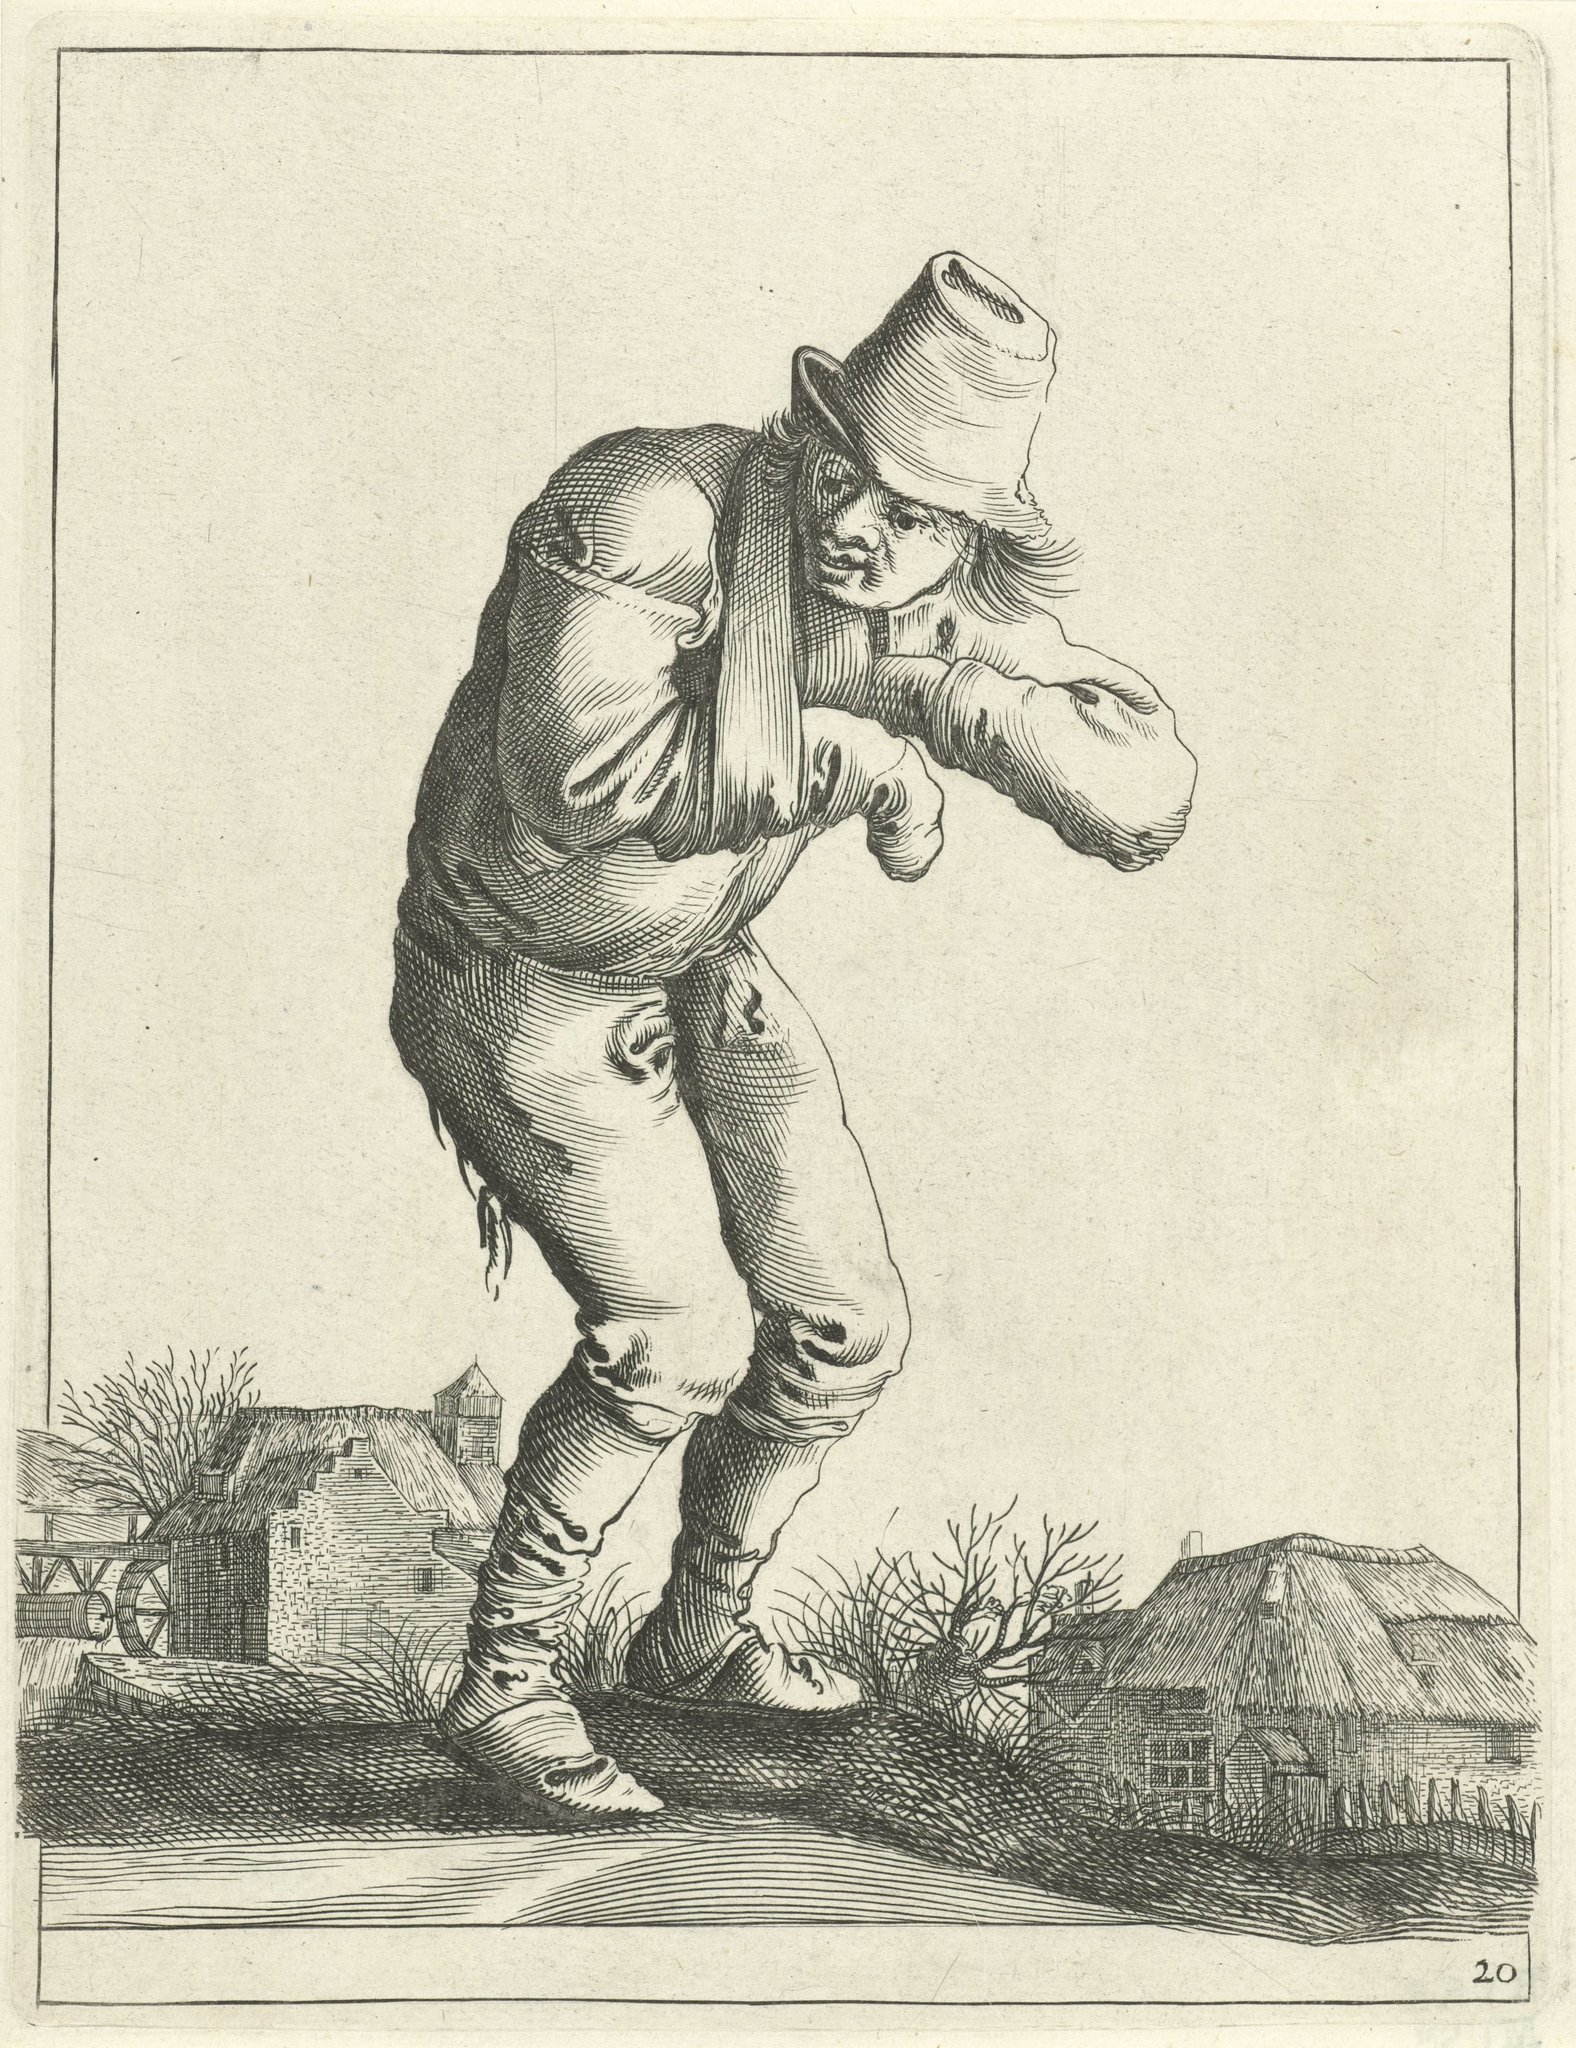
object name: print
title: Landloper met mitella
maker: pieter jansz quast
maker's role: draughtsman, painter, print maker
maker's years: 1605-1647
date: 1634-1638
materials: paper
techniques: engraving, etching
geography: the hague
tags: disabilities, deformations, watermill, beggar, farm or solitary house in landscape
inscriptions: collector's mark: Lugt 2165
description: Landschap met een bedelaar met een mitella en een hoed op zijn hoofd. Op de achtergrond een watermolen en een boerderij. De prent maakt deel uit van een serie van zesentwintig prenten met bedelaars en boeren.